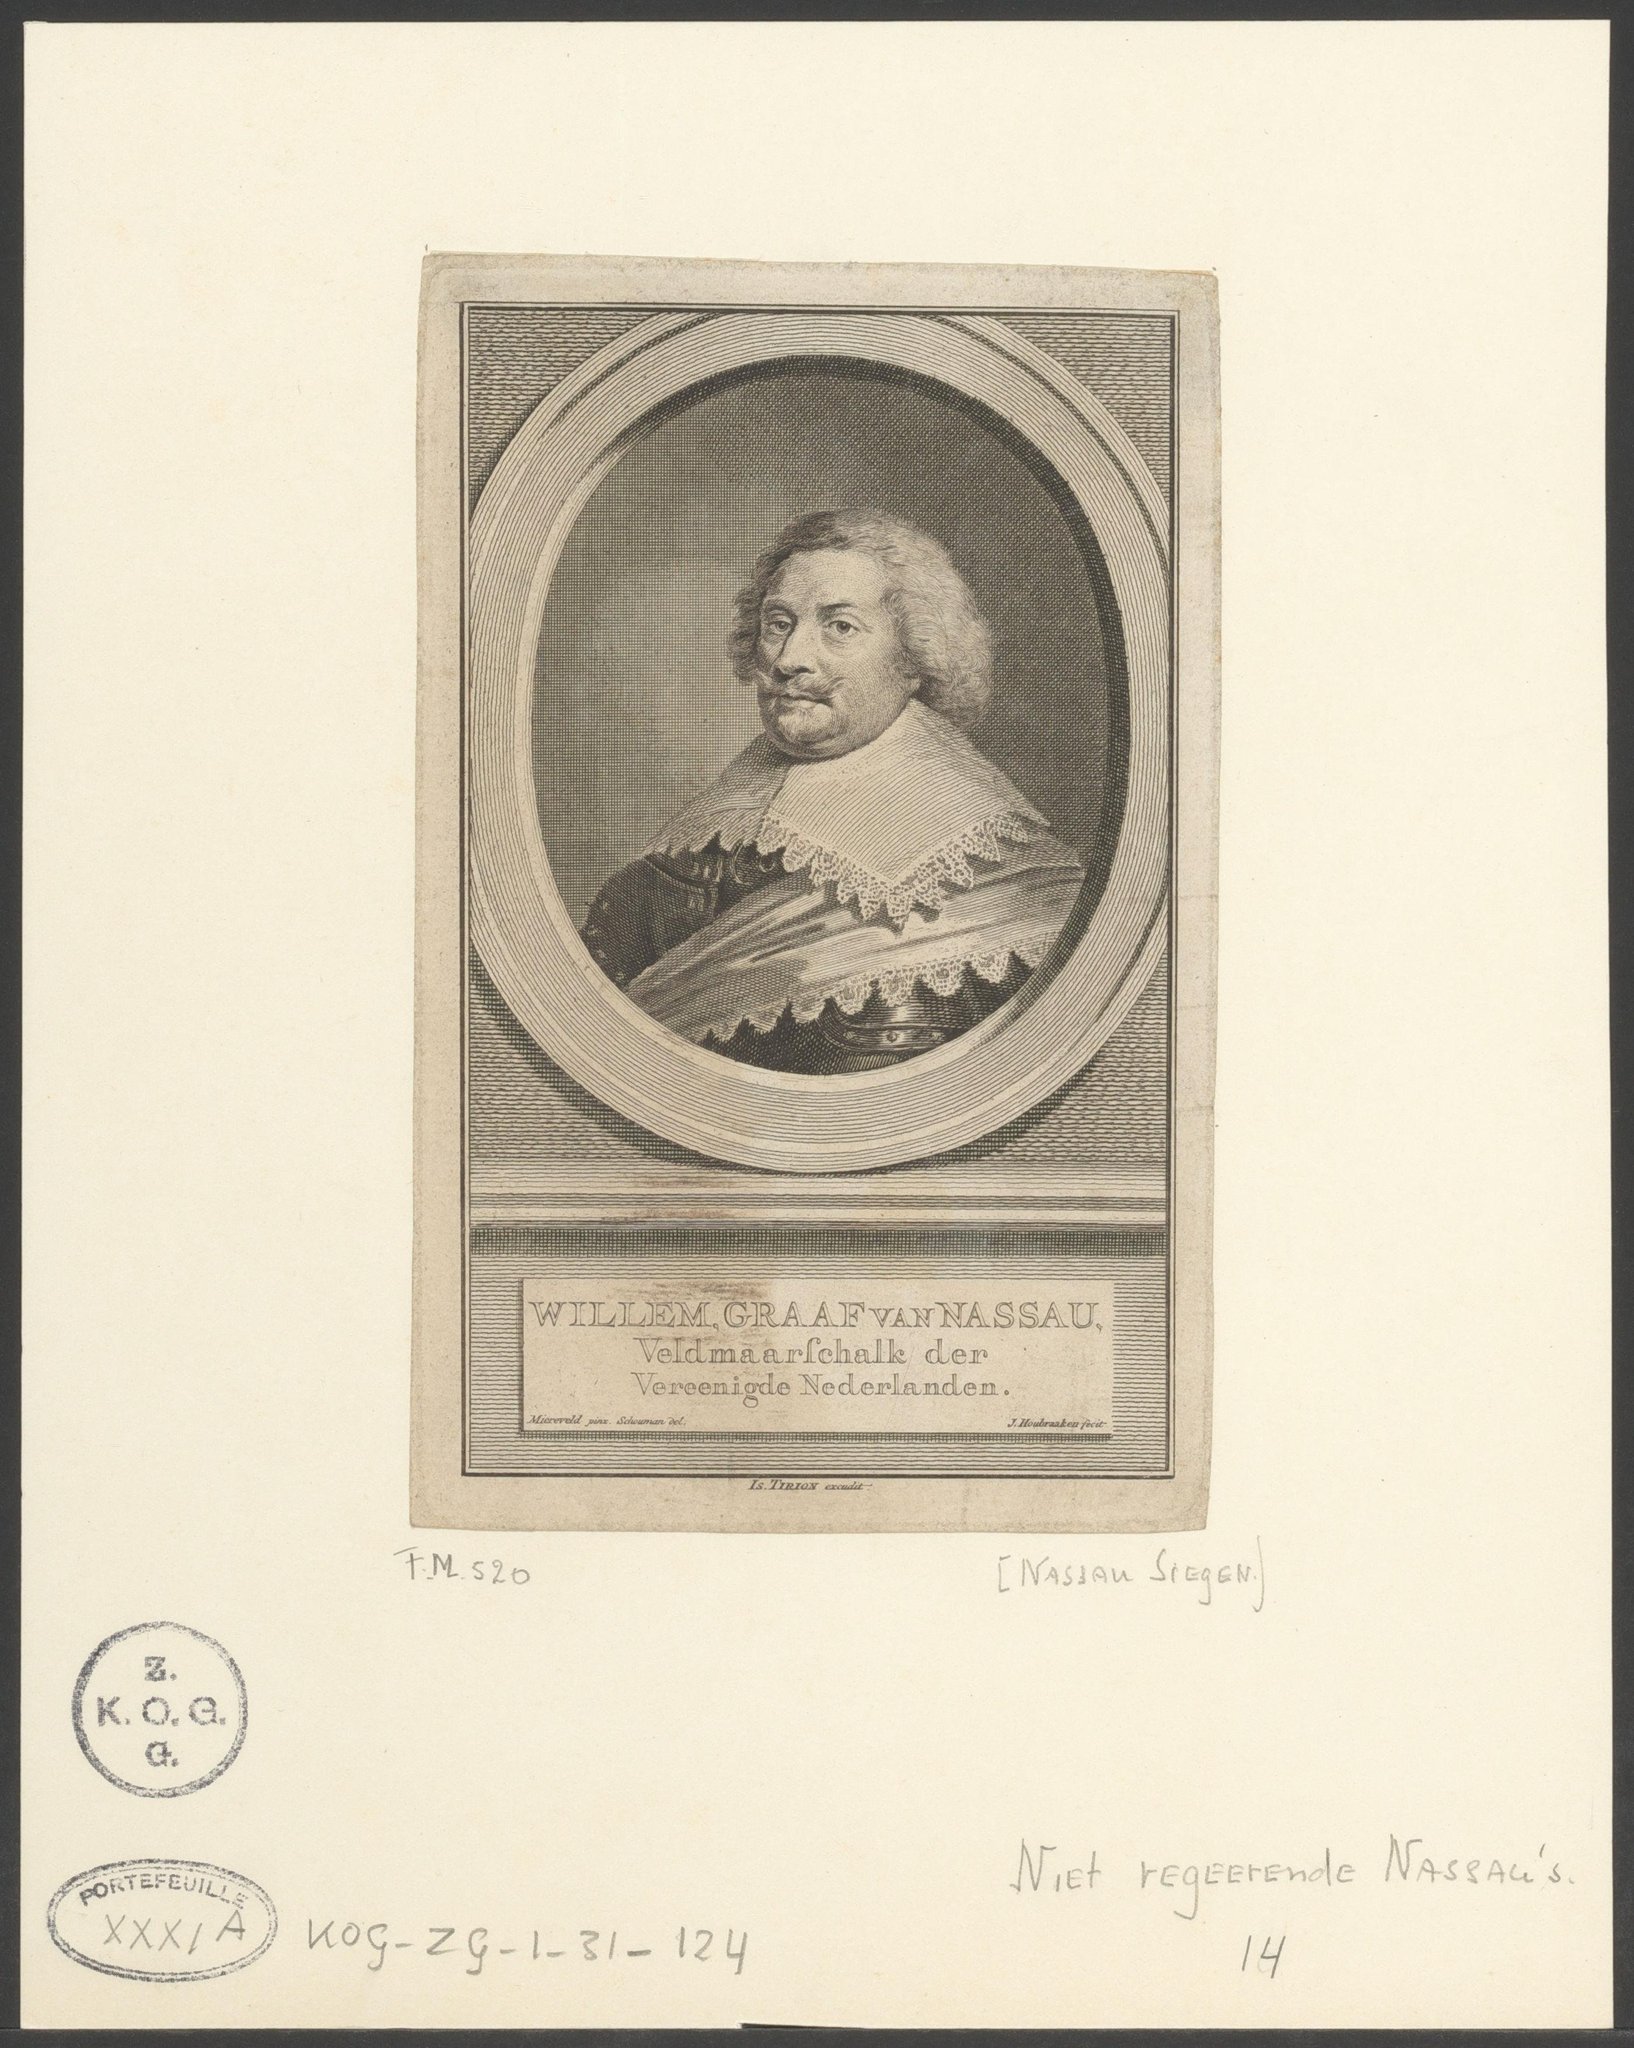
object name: book illustration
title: Portret van Willem, graaf van Nassau-Siegen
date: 1793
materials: paper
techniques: engraving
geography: amsterdam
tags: historical persons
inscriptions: stamp, collector's mark: Lugt 1641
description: Prent uit: Cerisier, Antoine M. Algemeene Geschiedenis der vereenigde Nederlandsche Provincien (...). Amsterdam en Leiden: Petrus den Hengst, Jan Augustijn Swalm en Abraham Honkoop I, 1793, dl. 6.